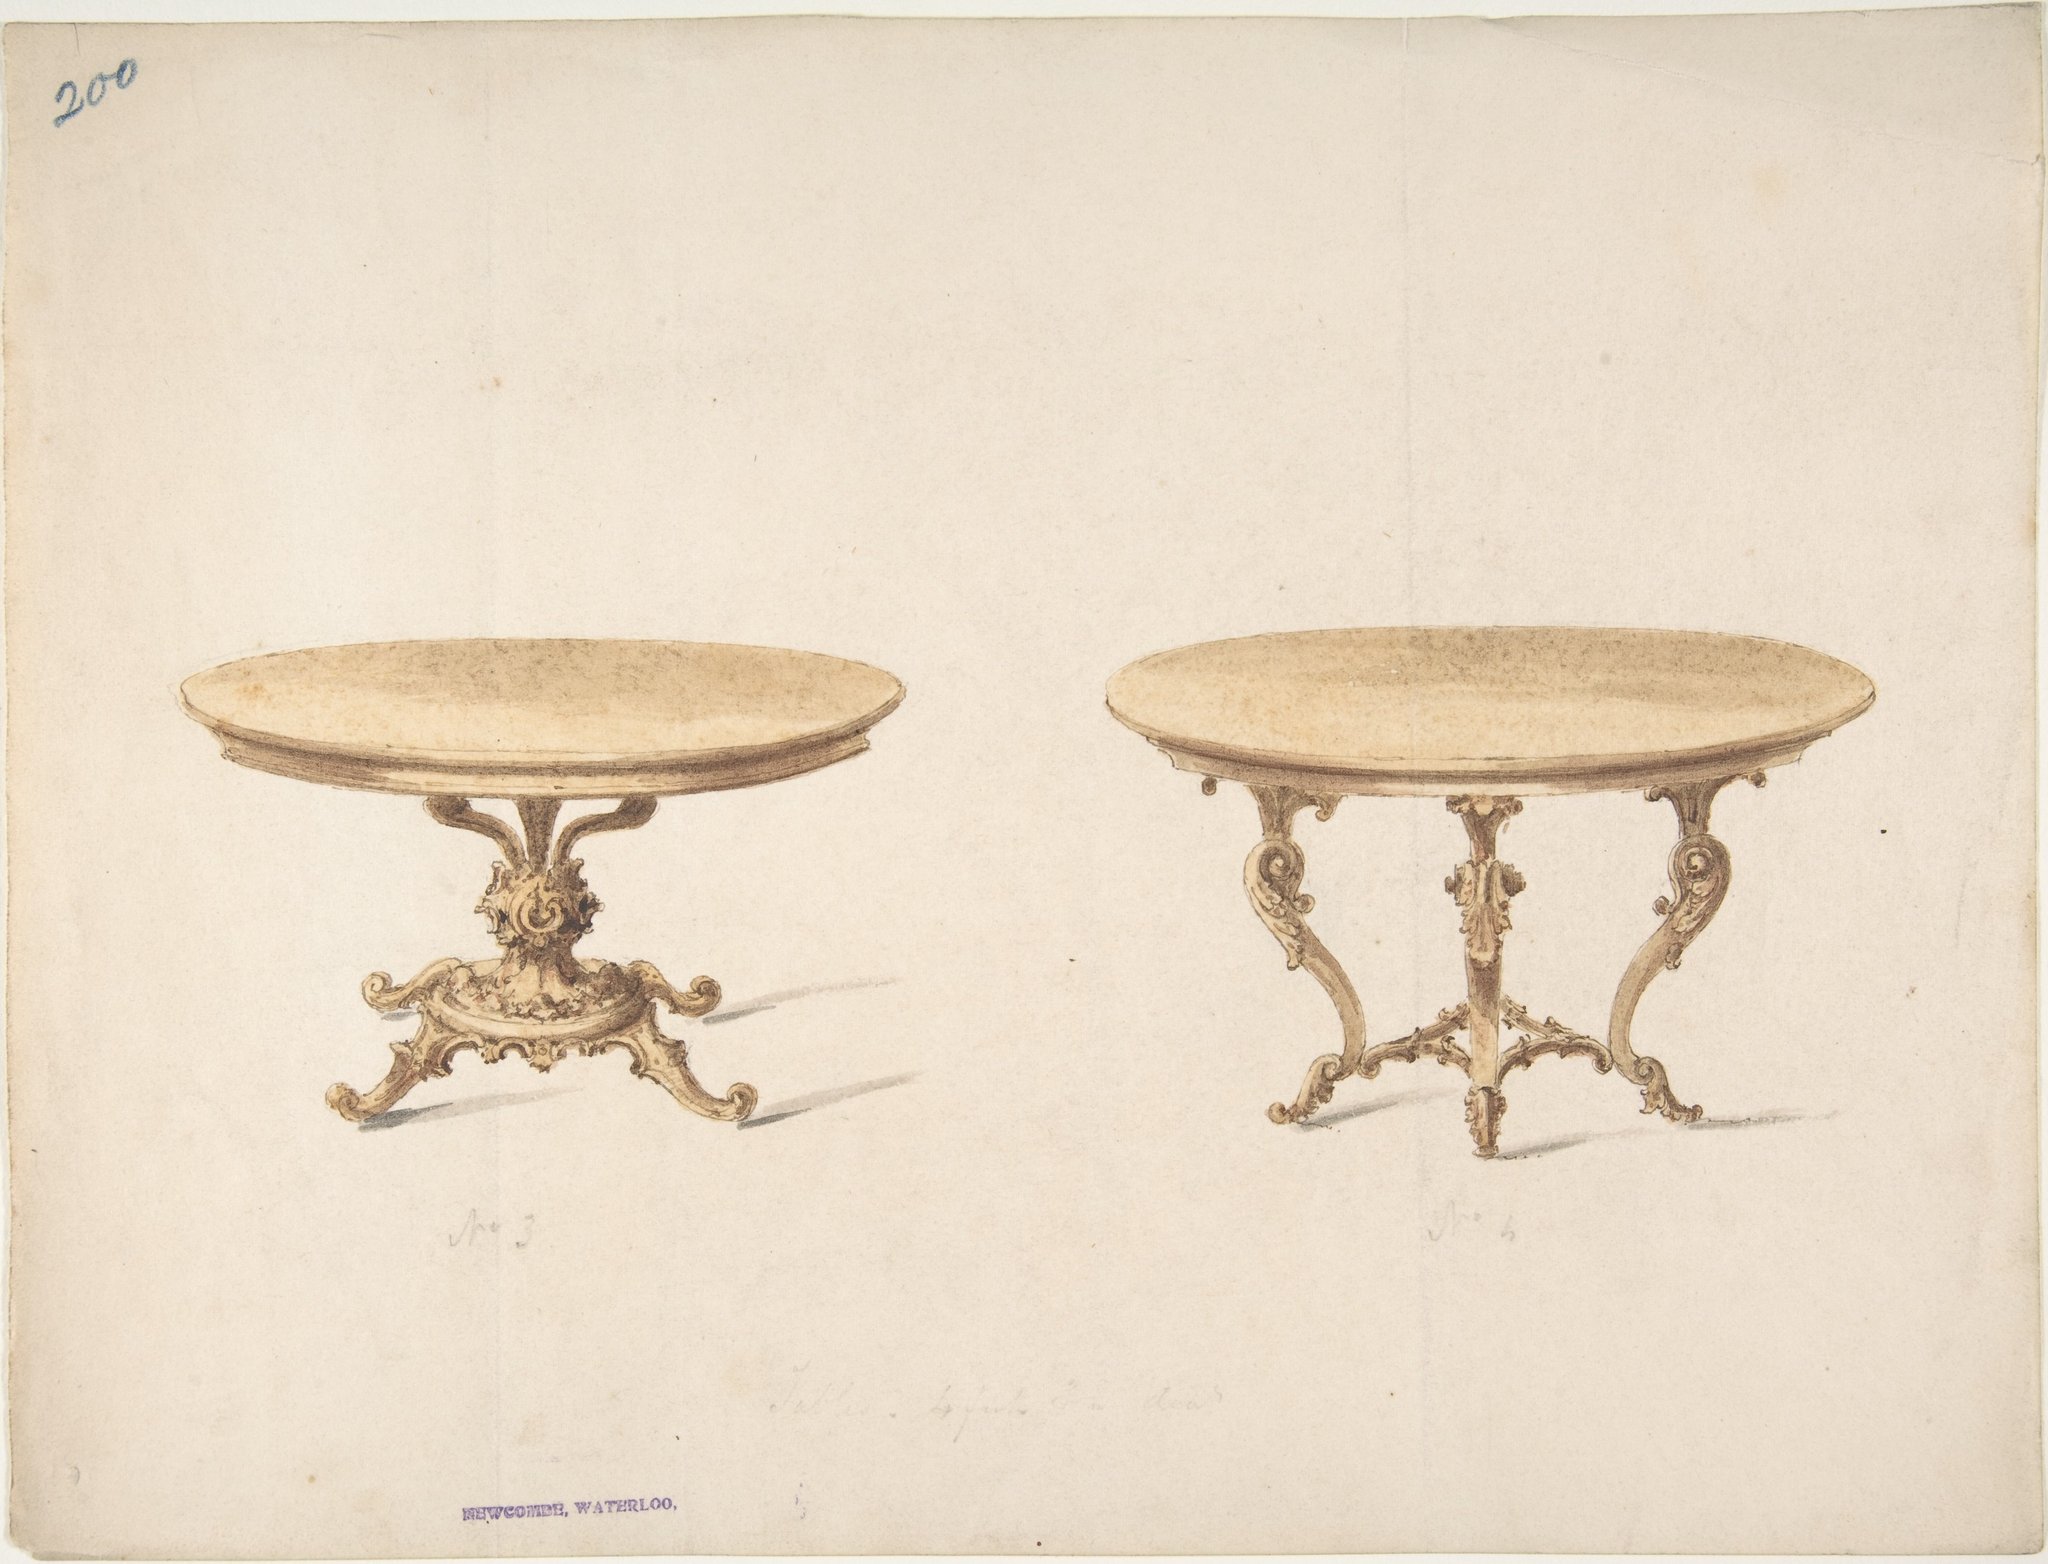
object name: drawing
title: Designs for Two Round Tables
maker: anonymous, british, 19th century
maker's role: artist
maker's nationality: british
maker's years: 1800-1900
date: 1801-1833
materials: ink, watercolor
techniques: brush, pen, wash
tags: tables